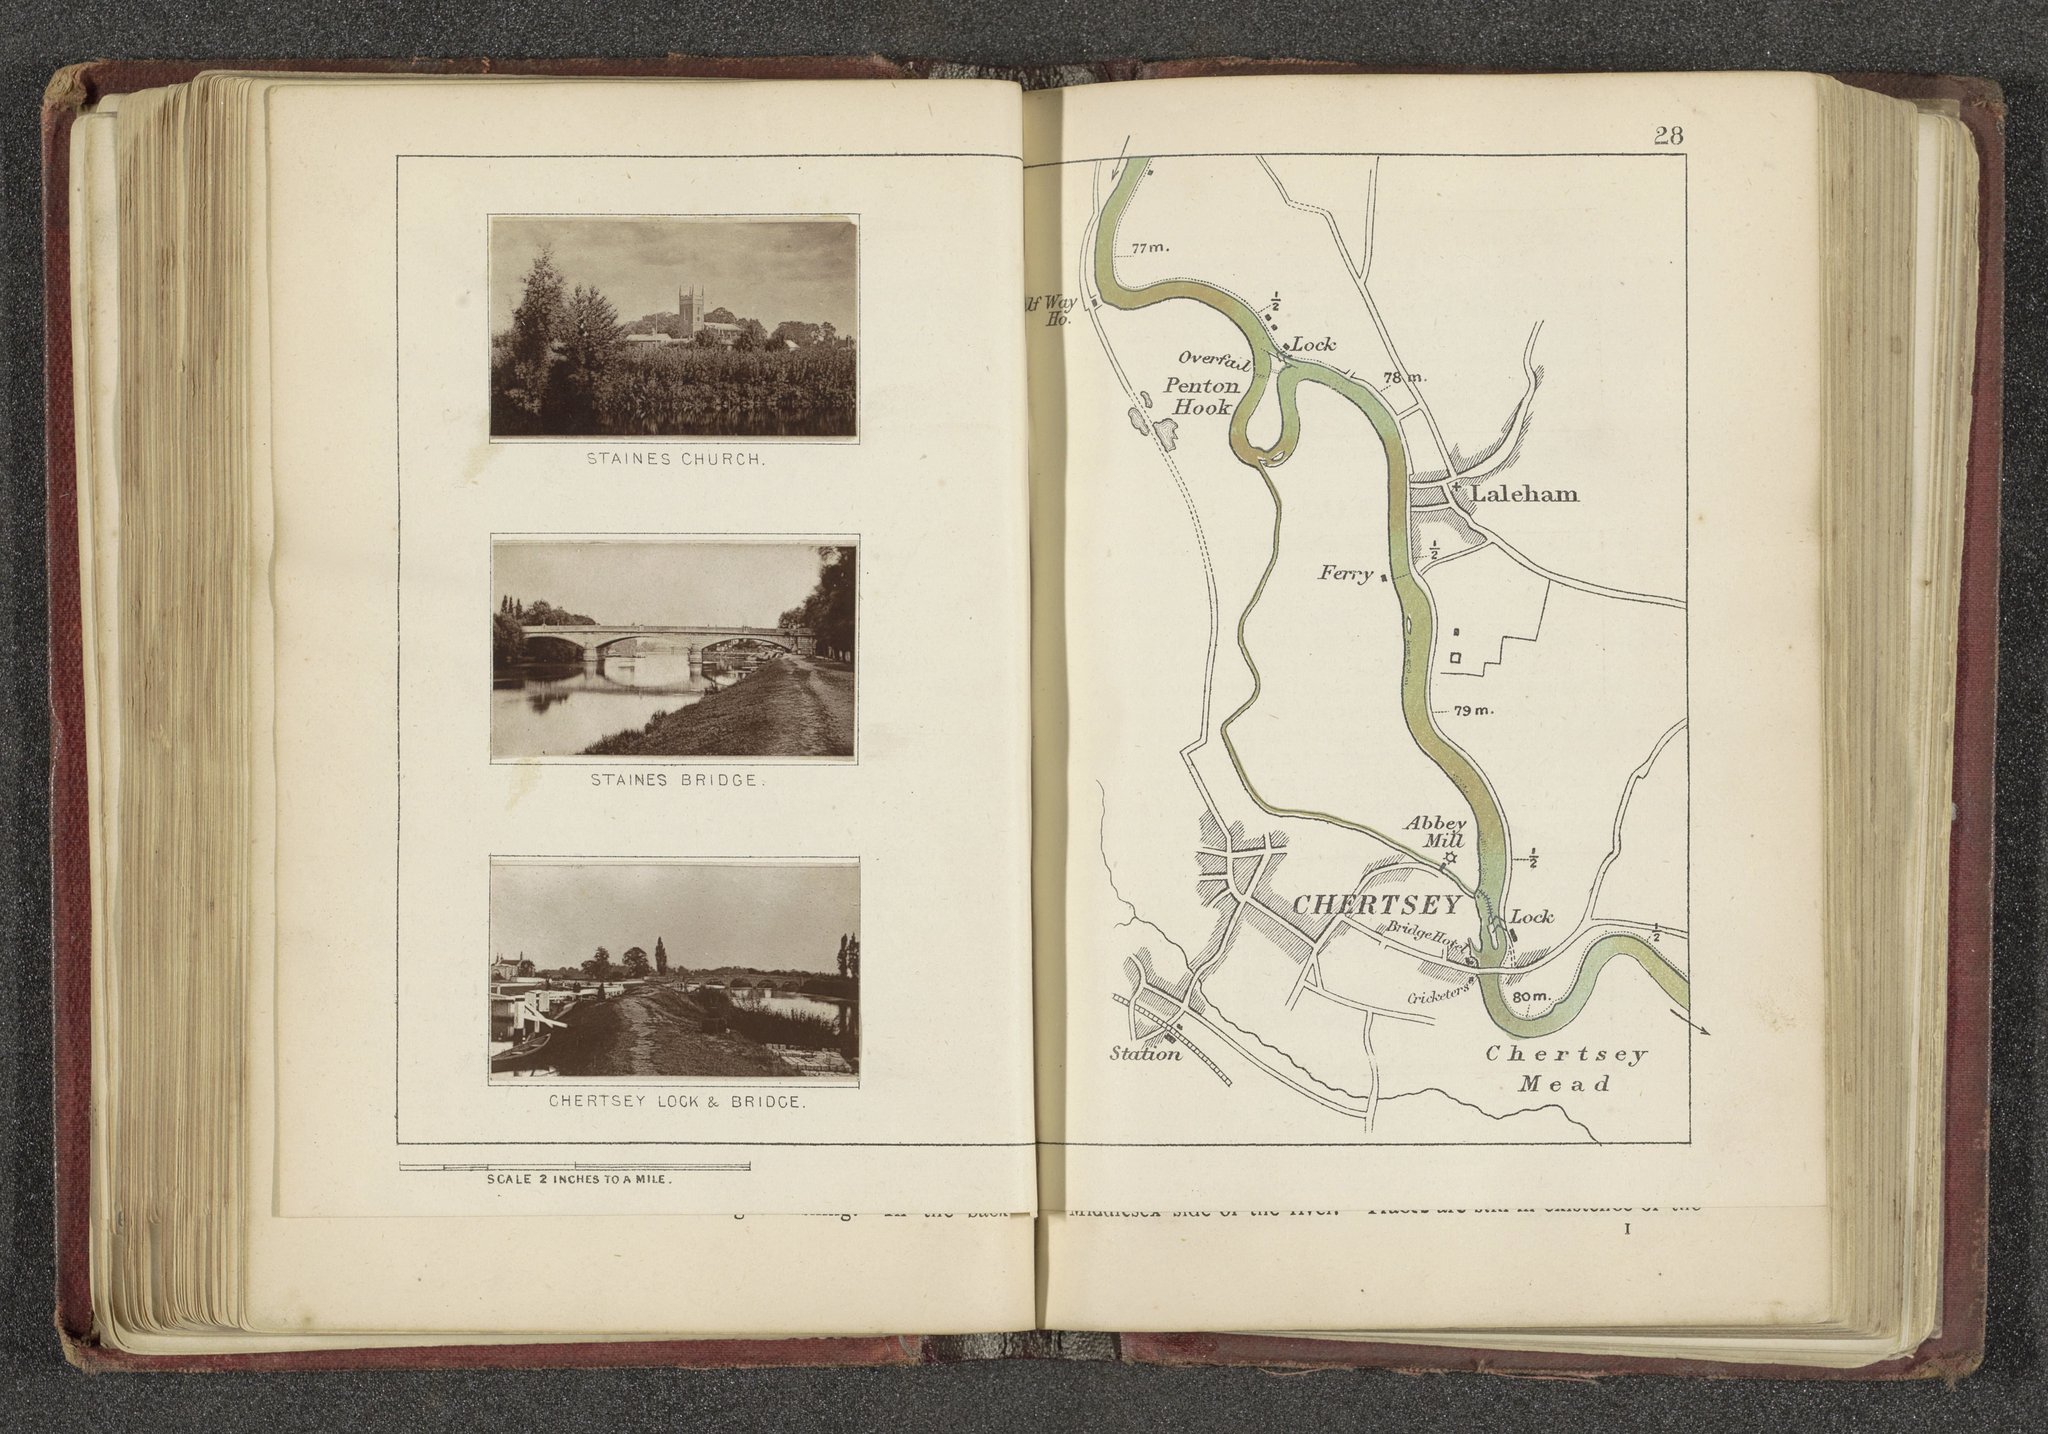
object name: page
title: Kaart met drie afbeeldingen van plaatsen langs de Theems in de buurt van Staines en Chertsey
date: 1878-1879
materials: paper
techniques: engraving, woodburytype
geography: surrey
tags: sluice, weir, river, church (exterior), bridge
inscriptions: inscription: ‘Staines church. Staines bridge. Chertsey lock & bridge.’, number: ‘28’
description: Boven: gezicht op de kerk van Staines, midden: gezicht op een brug in Staines, onder: sluis en brug bij Chertsey.